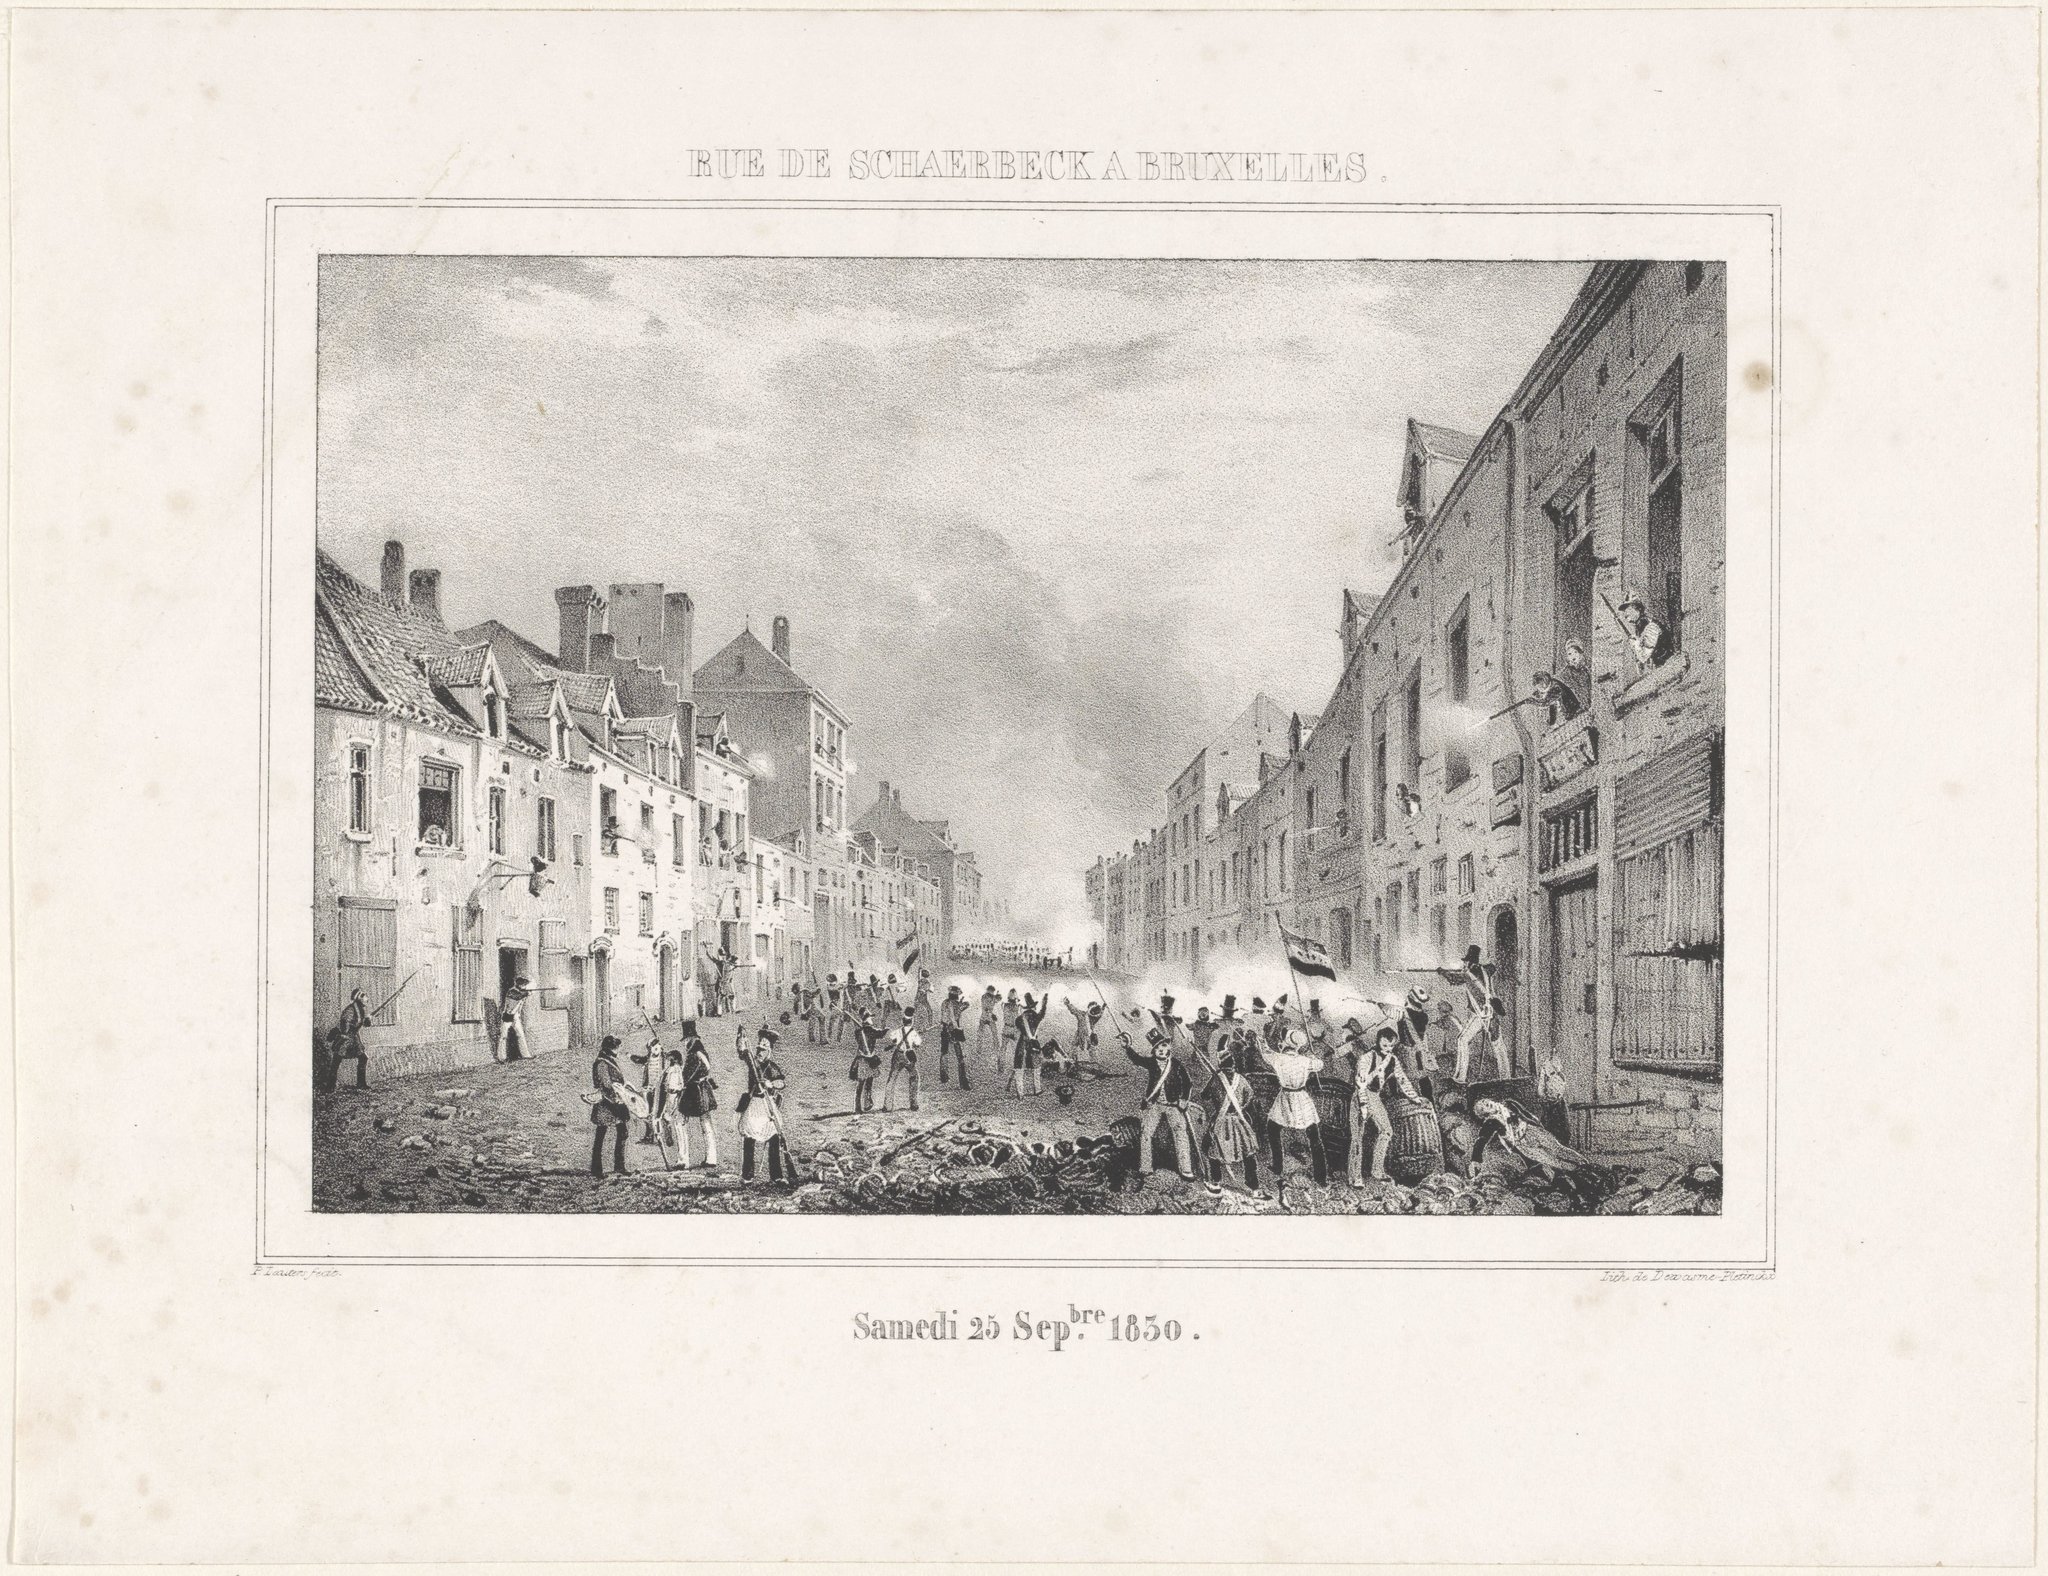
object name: print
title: Rue de Schaerbeck a Bruxelles. / Samedi 25 Sep.bre 1830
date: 1830-1831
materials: paper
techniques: lithograph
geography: brussels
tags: barricades ~ riot, battle, brussels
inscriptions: collector's mark: Lugt 2228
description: Gevechten tussen de Nederlandse troepen en Belgische opstandelingen in de Schaarbeekstraat te Brussel 25 september 1830. Onderdeel van een recueil met platen over de gebeurtenissen tijdens de Belgische Revolutie in Brussel, Antwerpen en andere steden in de periode 25 augustus 1830 tot 27 maart 1831.